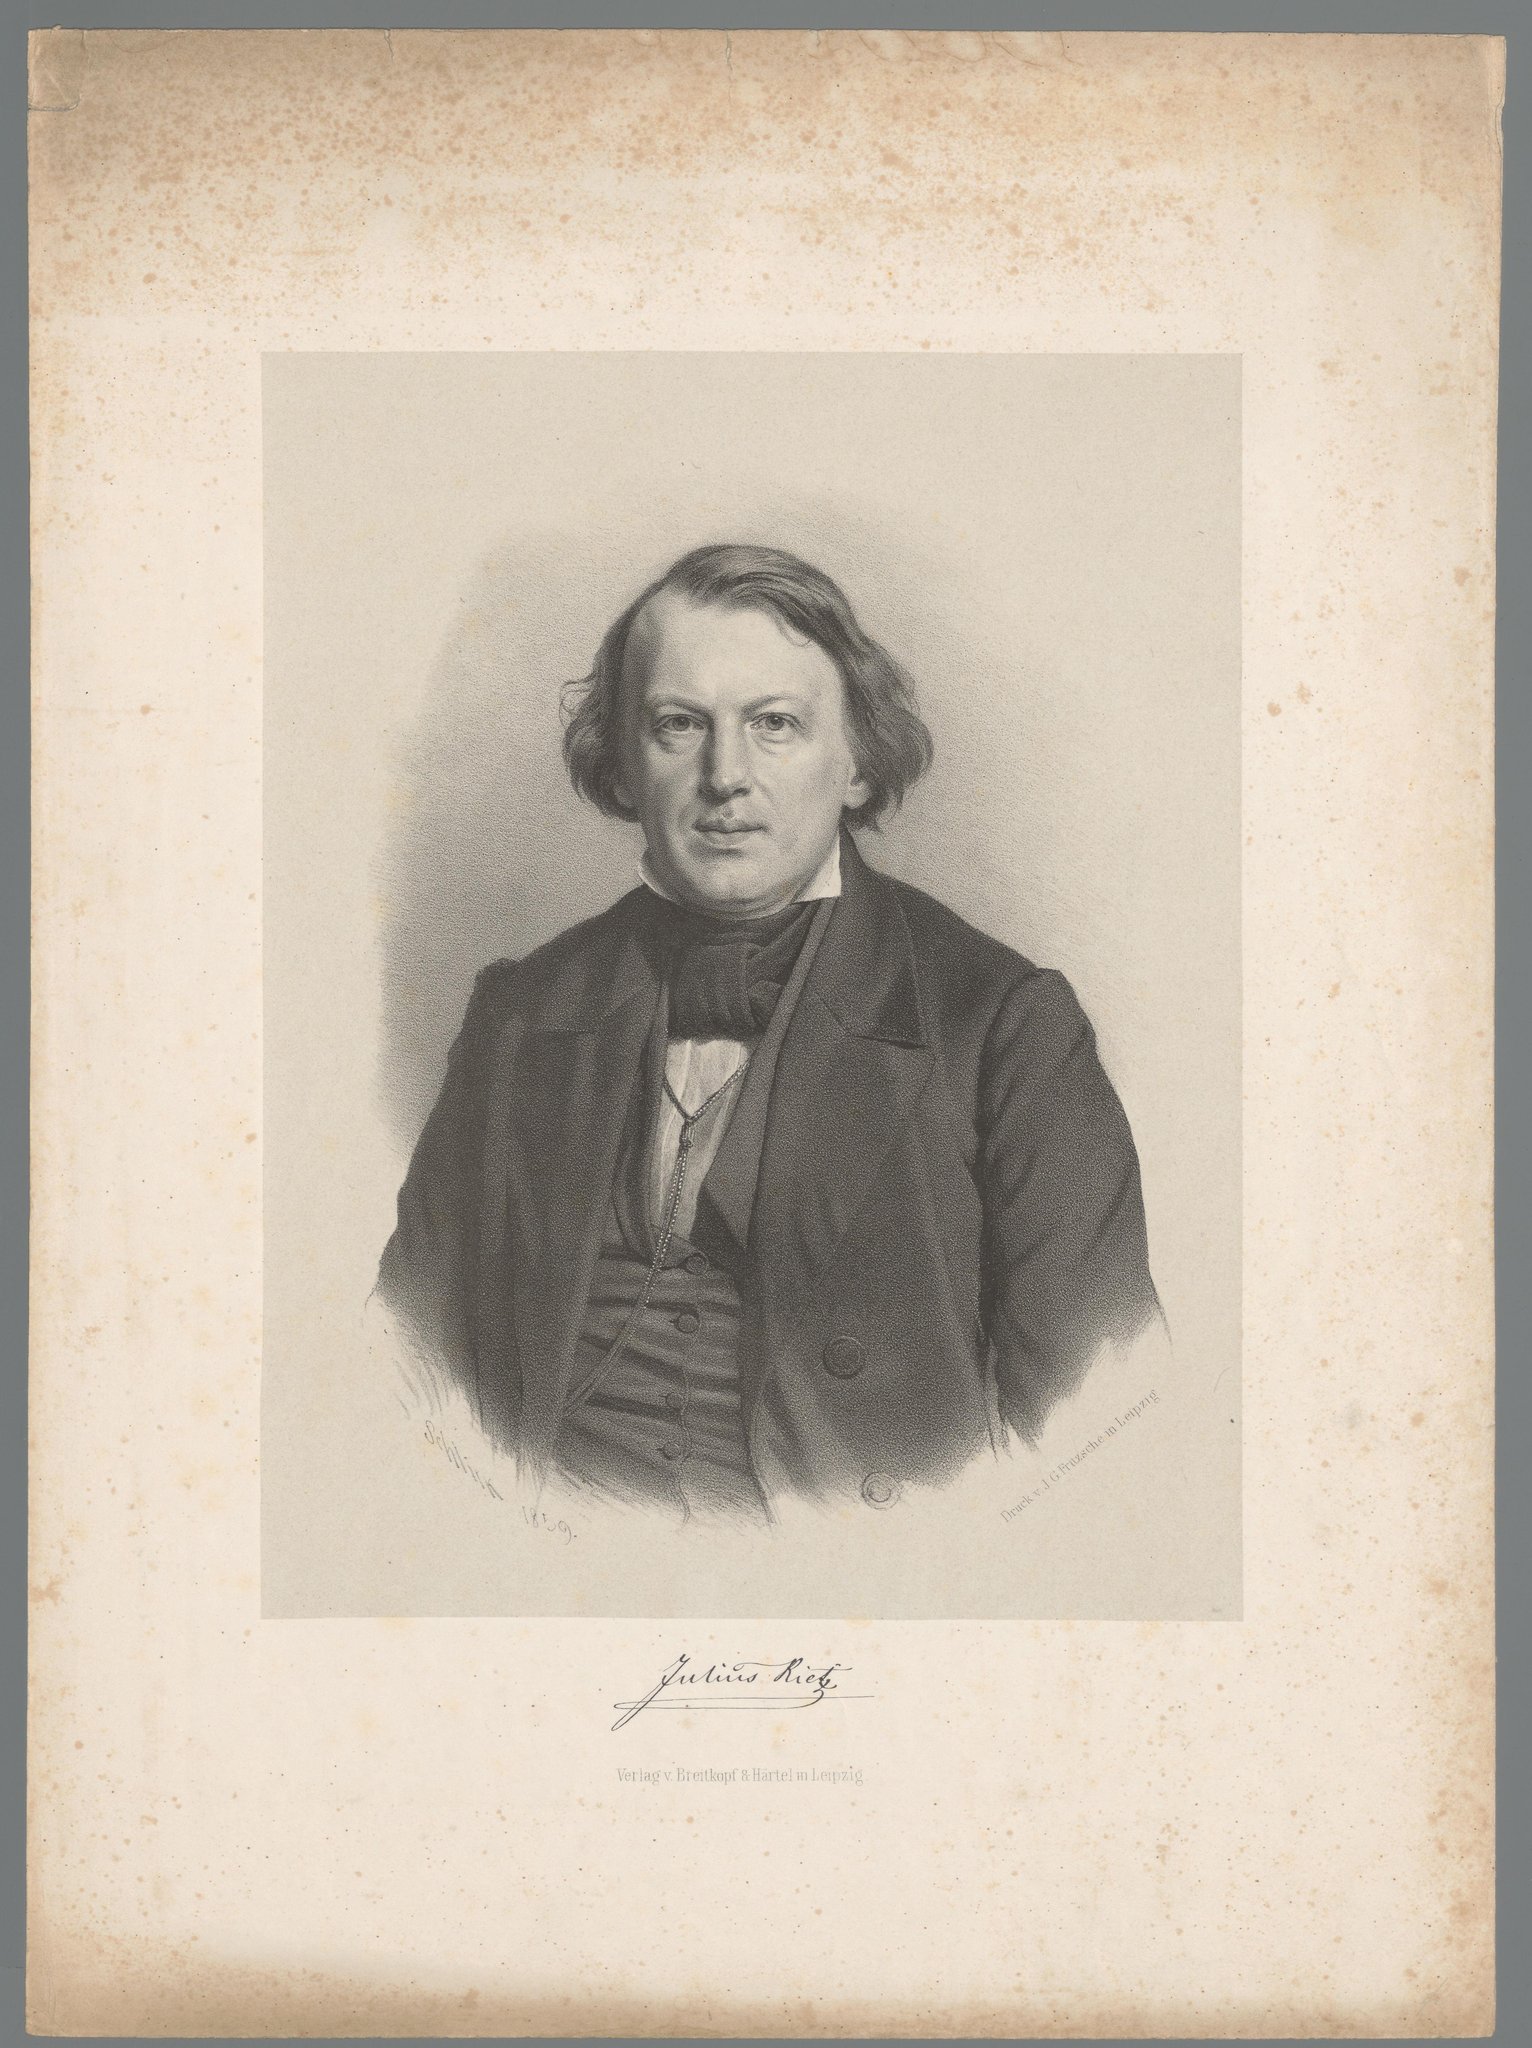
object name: print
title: Portret van Julius Rietz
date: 1859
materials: paper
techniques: lithograph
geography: leipzig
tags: berlin, historical persons, portrait of composer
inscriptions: collector's mark: Lugt 2228